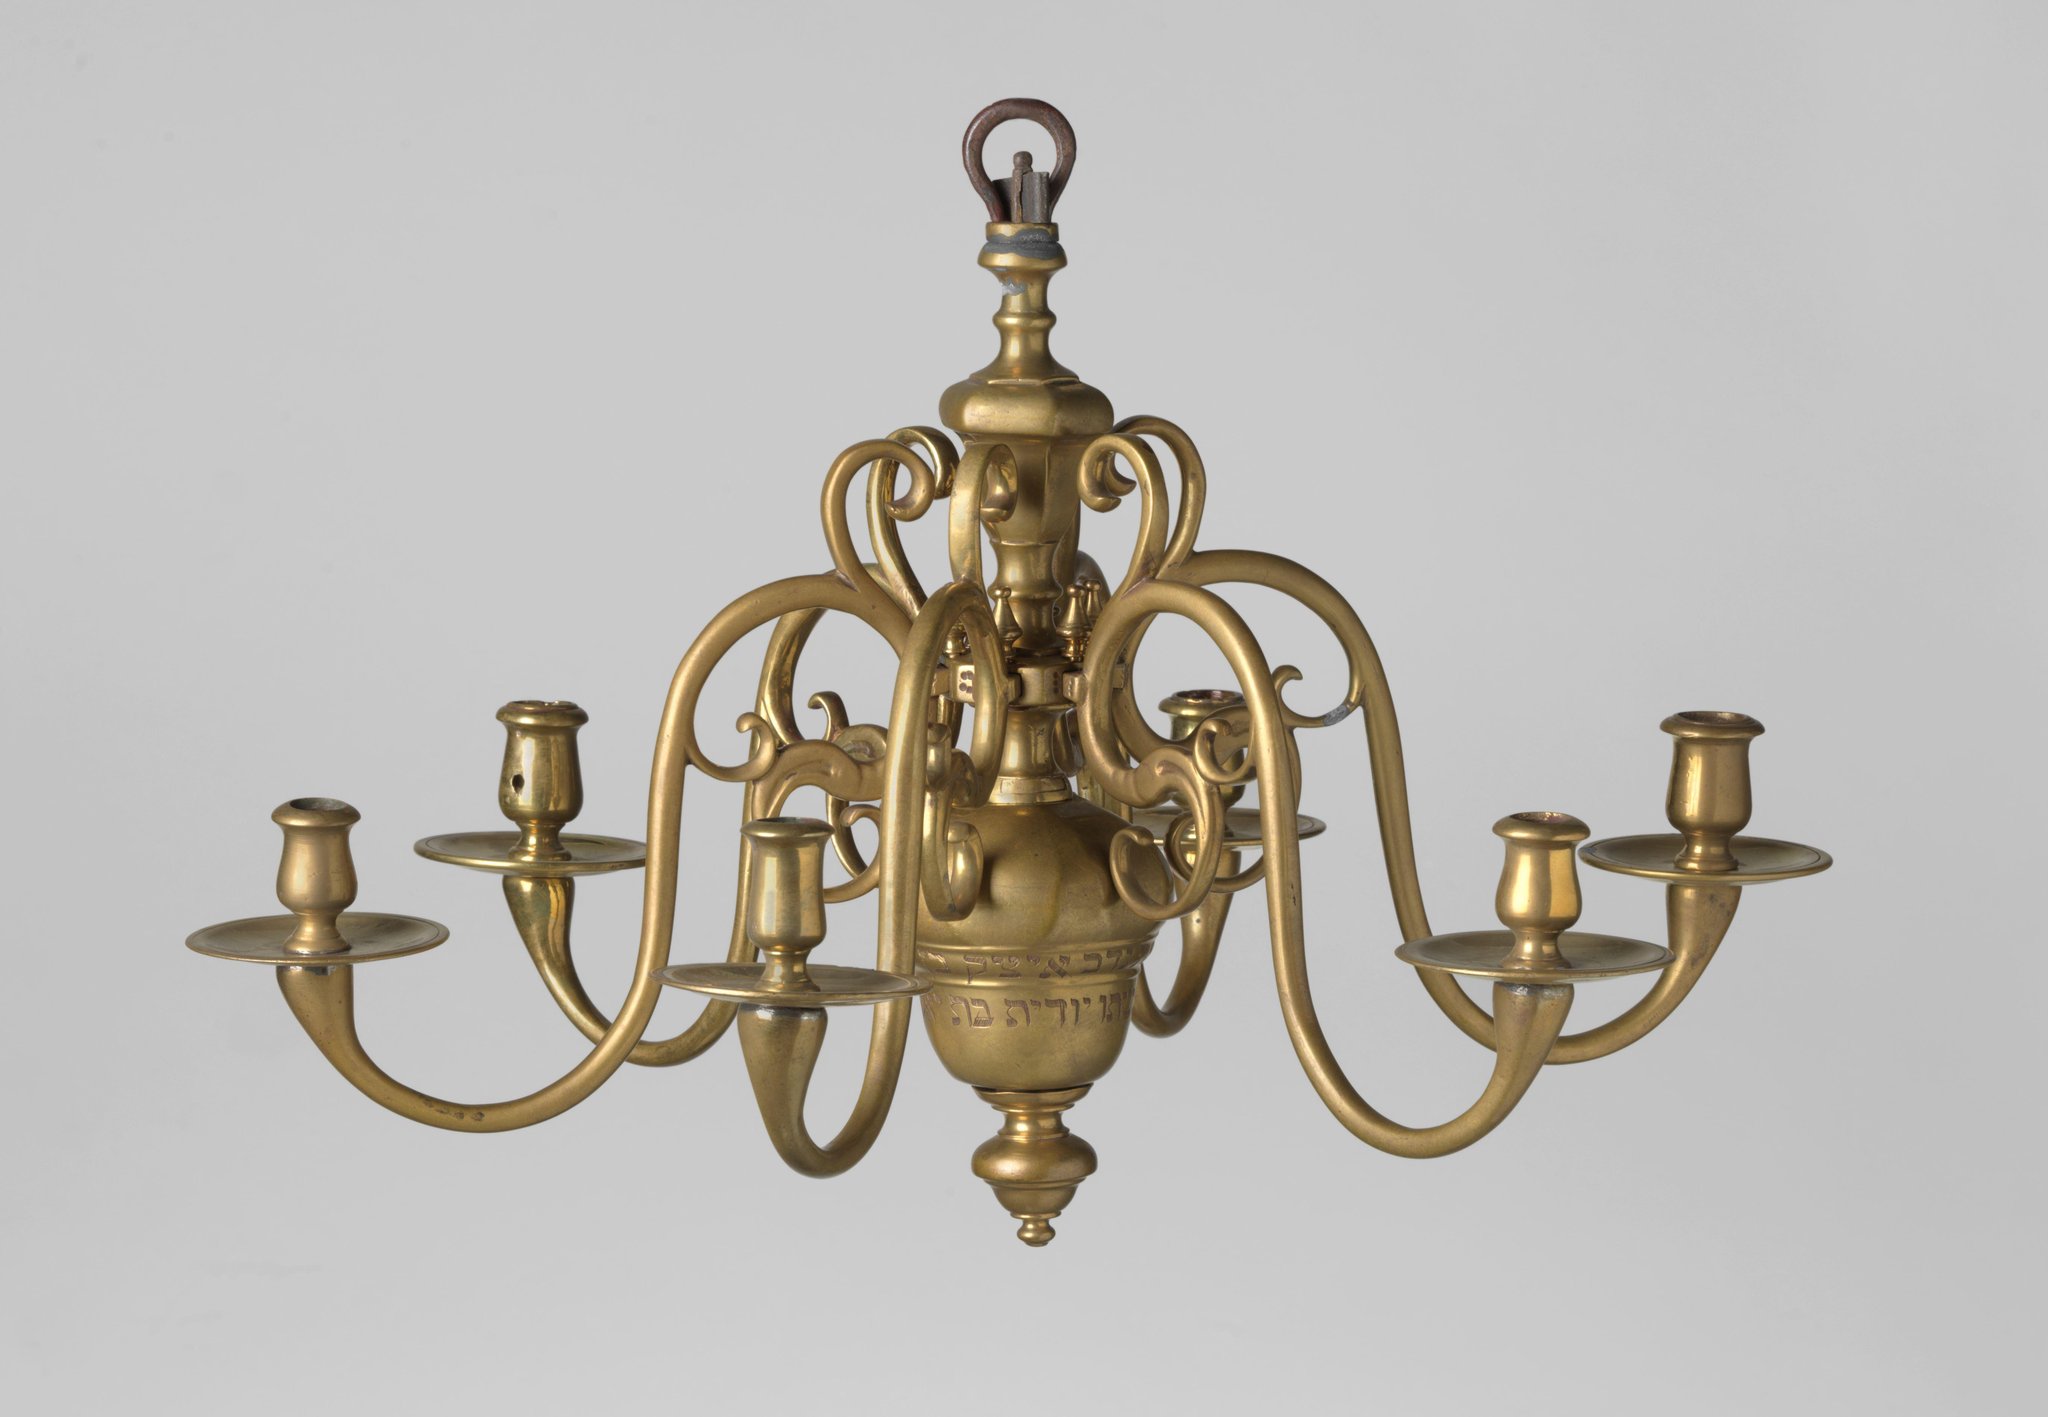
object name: chandelier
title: Arm met kaarsenhouder van kaarsenkroon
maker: Anonymous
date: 1795-1800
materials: brass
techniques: casting, screwed, turning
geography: amsterdam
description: De S-vormige arm heeft een krul op het eind aan de stamzijde en gaat naar buiten toe over in een verdikking met schroefgat. Daarin is de kaarsenhouder met de vetvanger vastgezet. De ronde houder heeft een holrond voetstuk, versmalt zich naar boven toe en heeft vervolgens een uitstekende rand. De vetvanger heeft aan de bovenkant een gegroefde ring. Dit is de eerste arm, genummerd met 1 ronde punt.